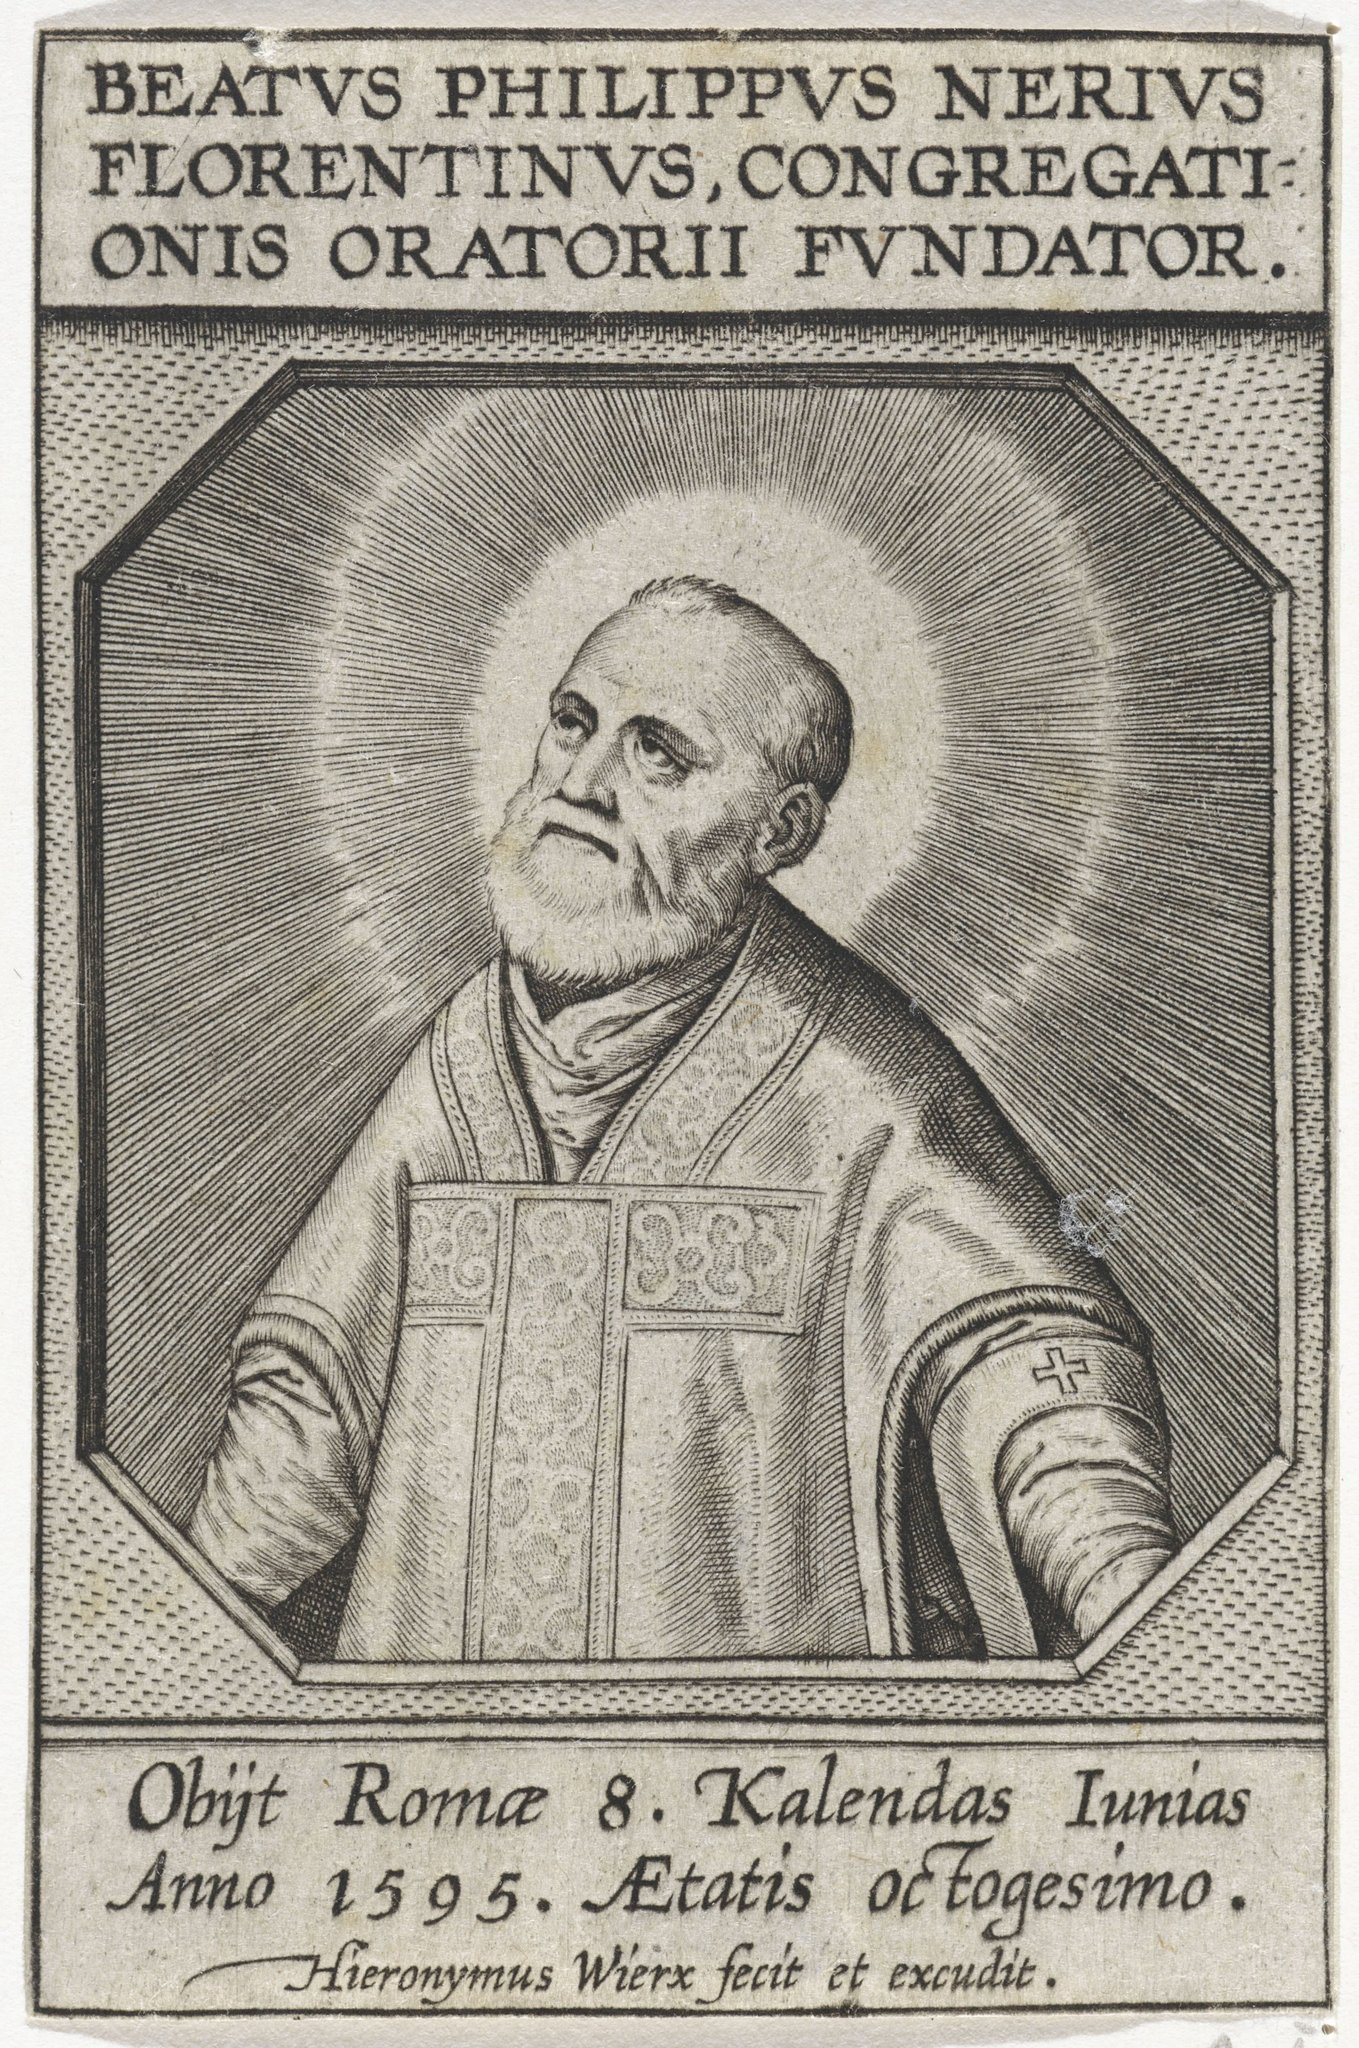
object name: print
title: Portret van de H. Filippo Neri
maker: hieronymus wierix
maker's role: draughtsman, print maker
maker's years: 1553-1619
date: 1595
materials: paper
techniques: engraving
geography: antwerp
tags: rome, the founder of the congregation of the oratory (oratorians) philip neri; possible attributes: lily, rosary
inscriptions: collector's mark: Lugt 2228, collector's mark: Lugt 514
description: De prent heeft een drieregelig bovenschrift in het Latijn. In de marge biografische gegevens van de geportretteerde in het Latijn.